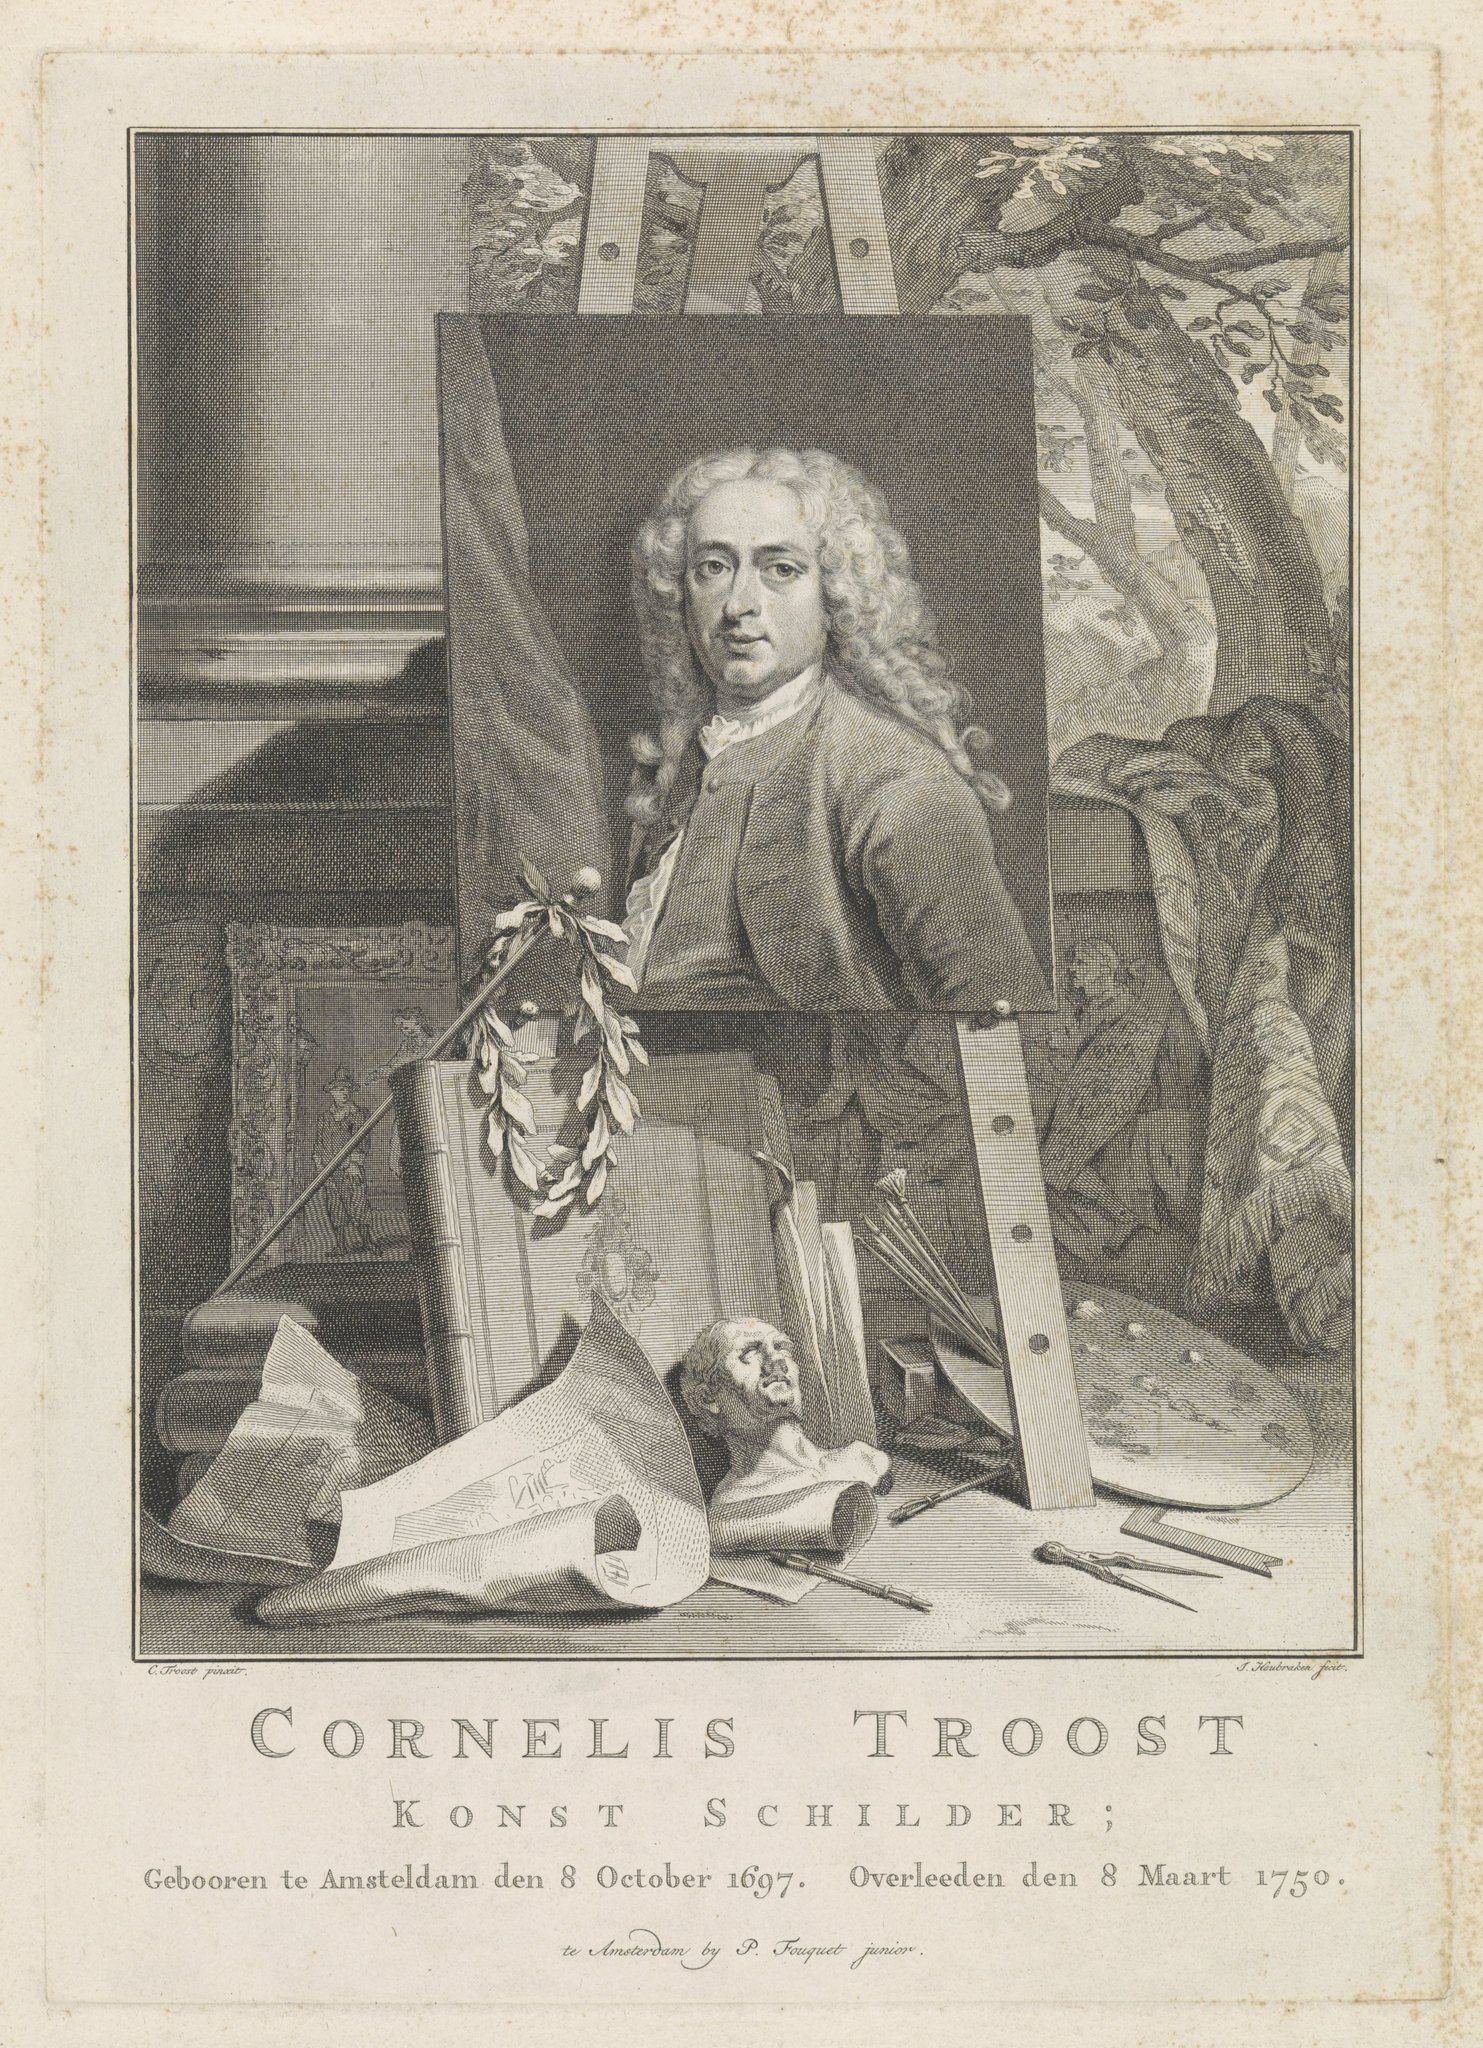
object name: print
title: Portret van Cornelis Troost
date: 1760-1780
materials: paper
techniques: engraving, etching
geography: amsterdam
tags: amsterdam, painter, print maker, draughtsman, cornelis troost, portrait, self-portrait of painter, tools, implements of painter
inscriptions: collector's mark: Lugt 2166, collector's mark: Lugt 2760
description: Portret naar links van de schilder Cornelis Troost. Het schilderij met zijn portret staat op een schildersezel op een bordes en is omringd door de attributen van de schilder- en graveerkunst. Onder de ezel liggen palet en penselen, een gebeeldhouwde kop, tekenstiften, boeken en tekeningen. Links staat de schildersstok, waaraan een lauwerkrans hangt. Daarachter een schilderij in lijst. In de achtergrond een doorkijk naar een landschap. Onder de voorstelling de naam en gegevens van de geportretteerde in drie regels in het Nederlands.